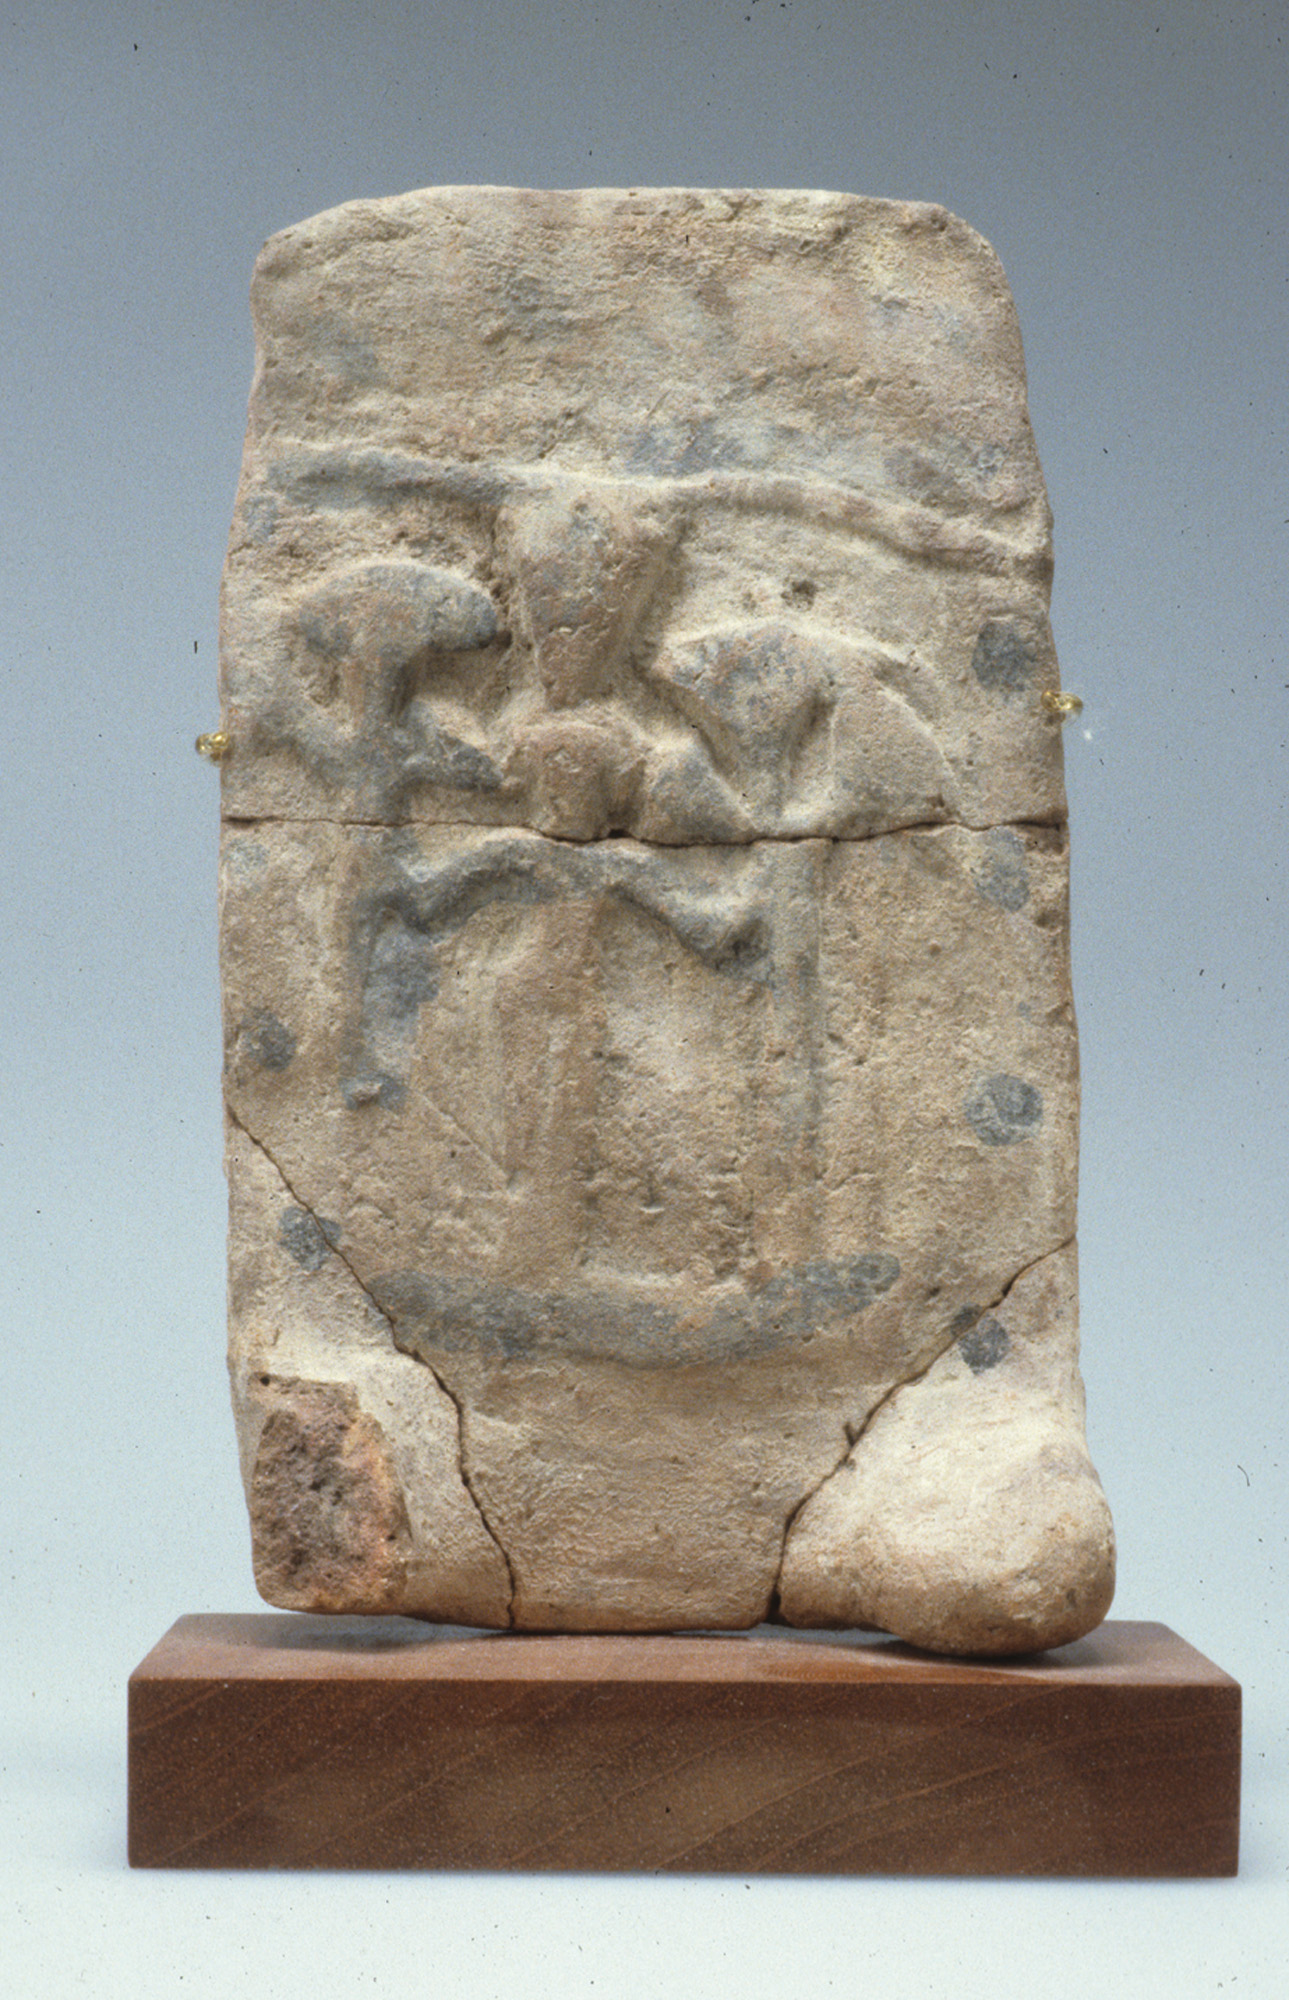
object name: stela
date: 945-715 BCE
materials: pottery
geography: egypt